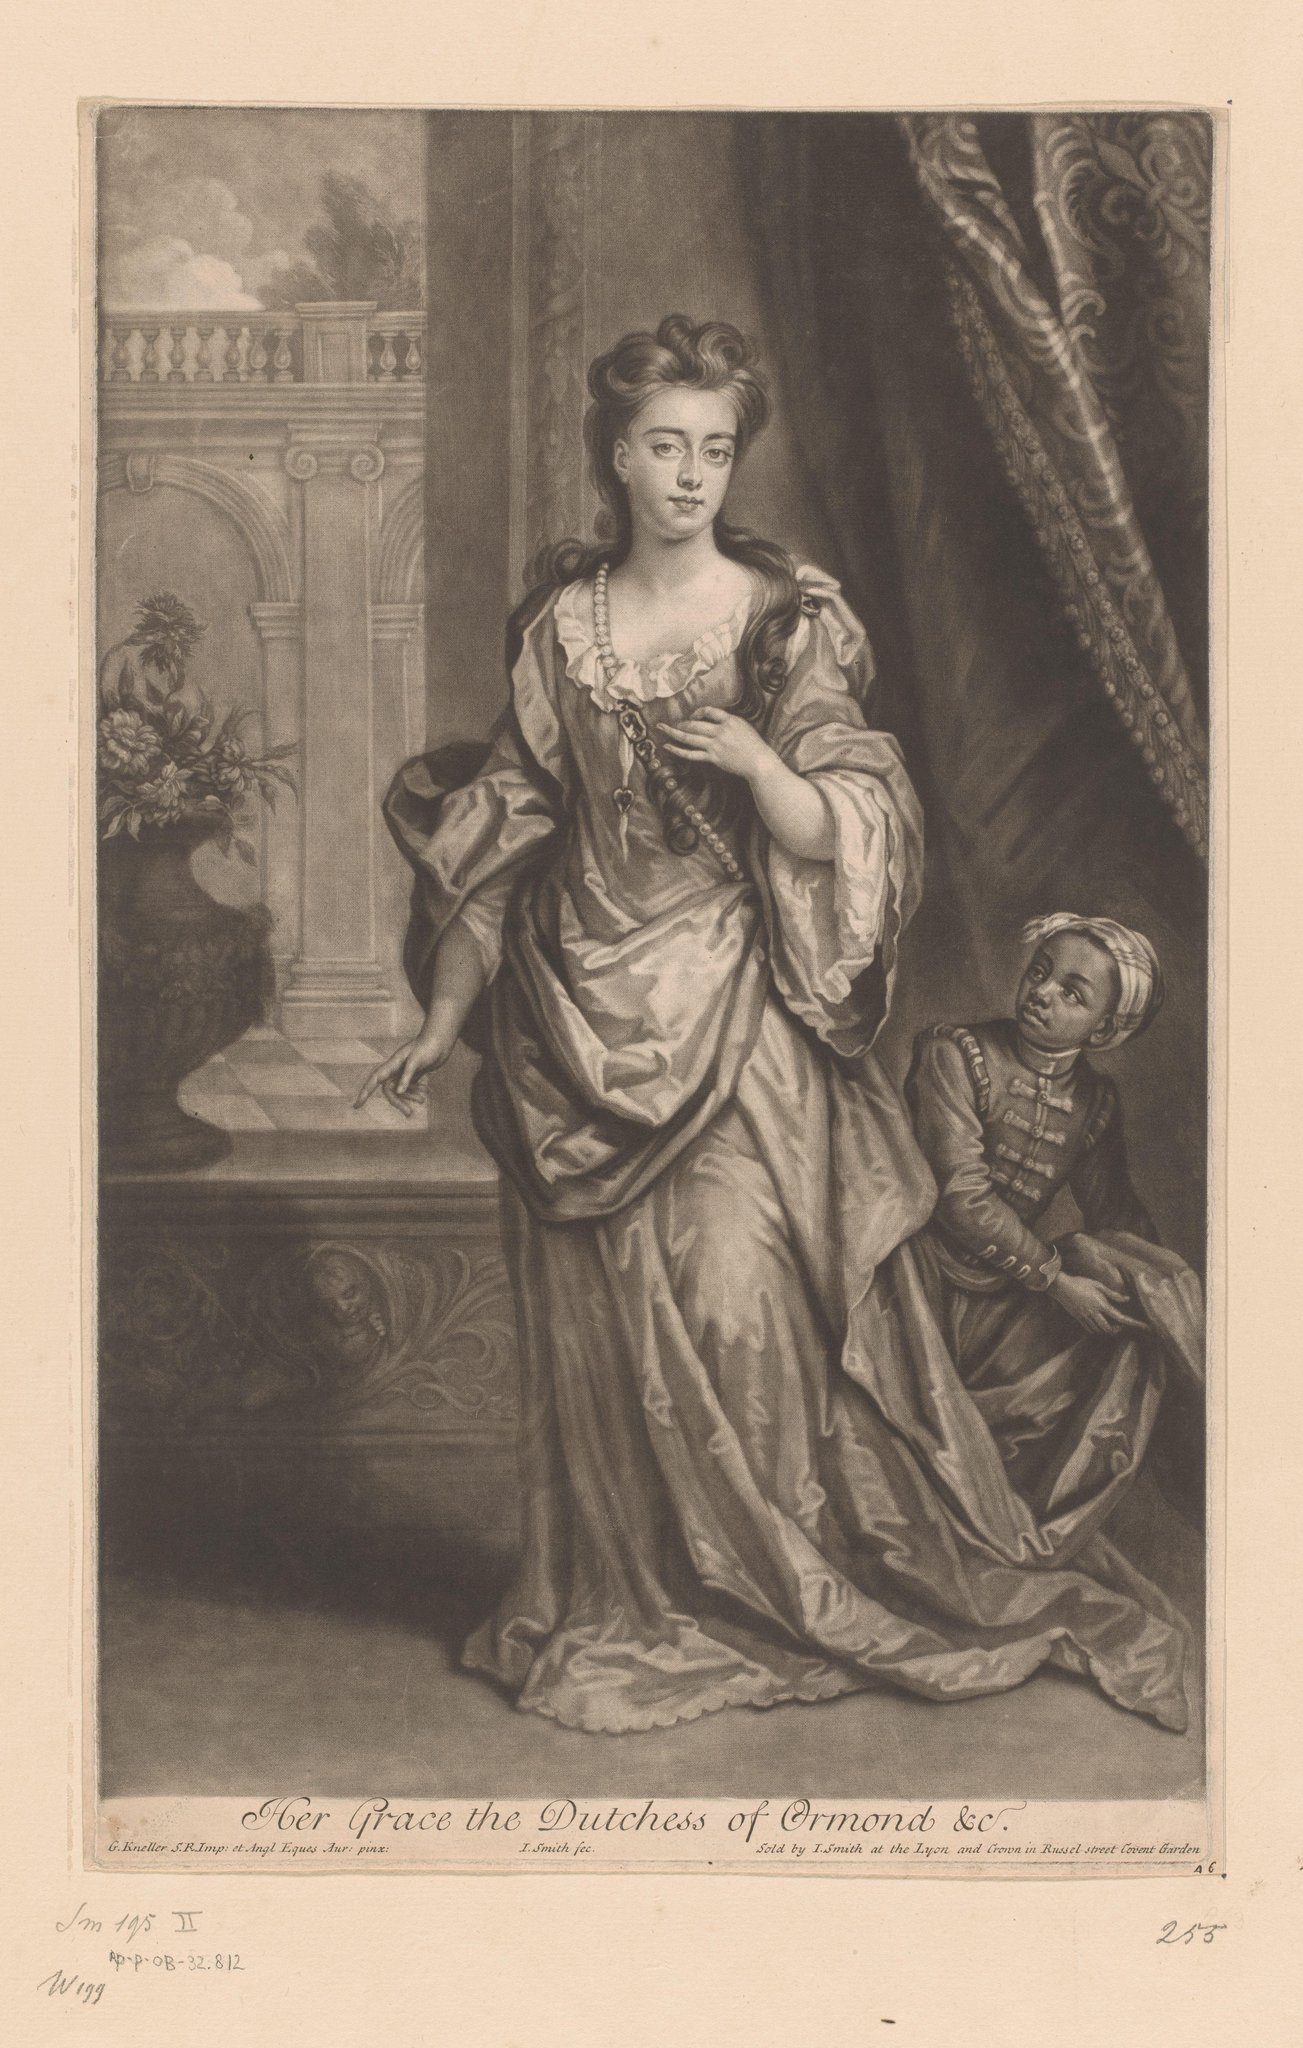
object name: print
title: Portret van Mary Somerset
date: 1685-1742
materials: paper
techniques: mezzotint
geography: london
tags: adolescent, young woman, maiden, historical persons, page, footboy, house personnel, servants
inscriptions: number: ‘16’, collector's mark: Lugt 240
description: Een zwart kind, mogelijk een bediende of page, houdt de sleep van de jurk van de witte vrouw vast.